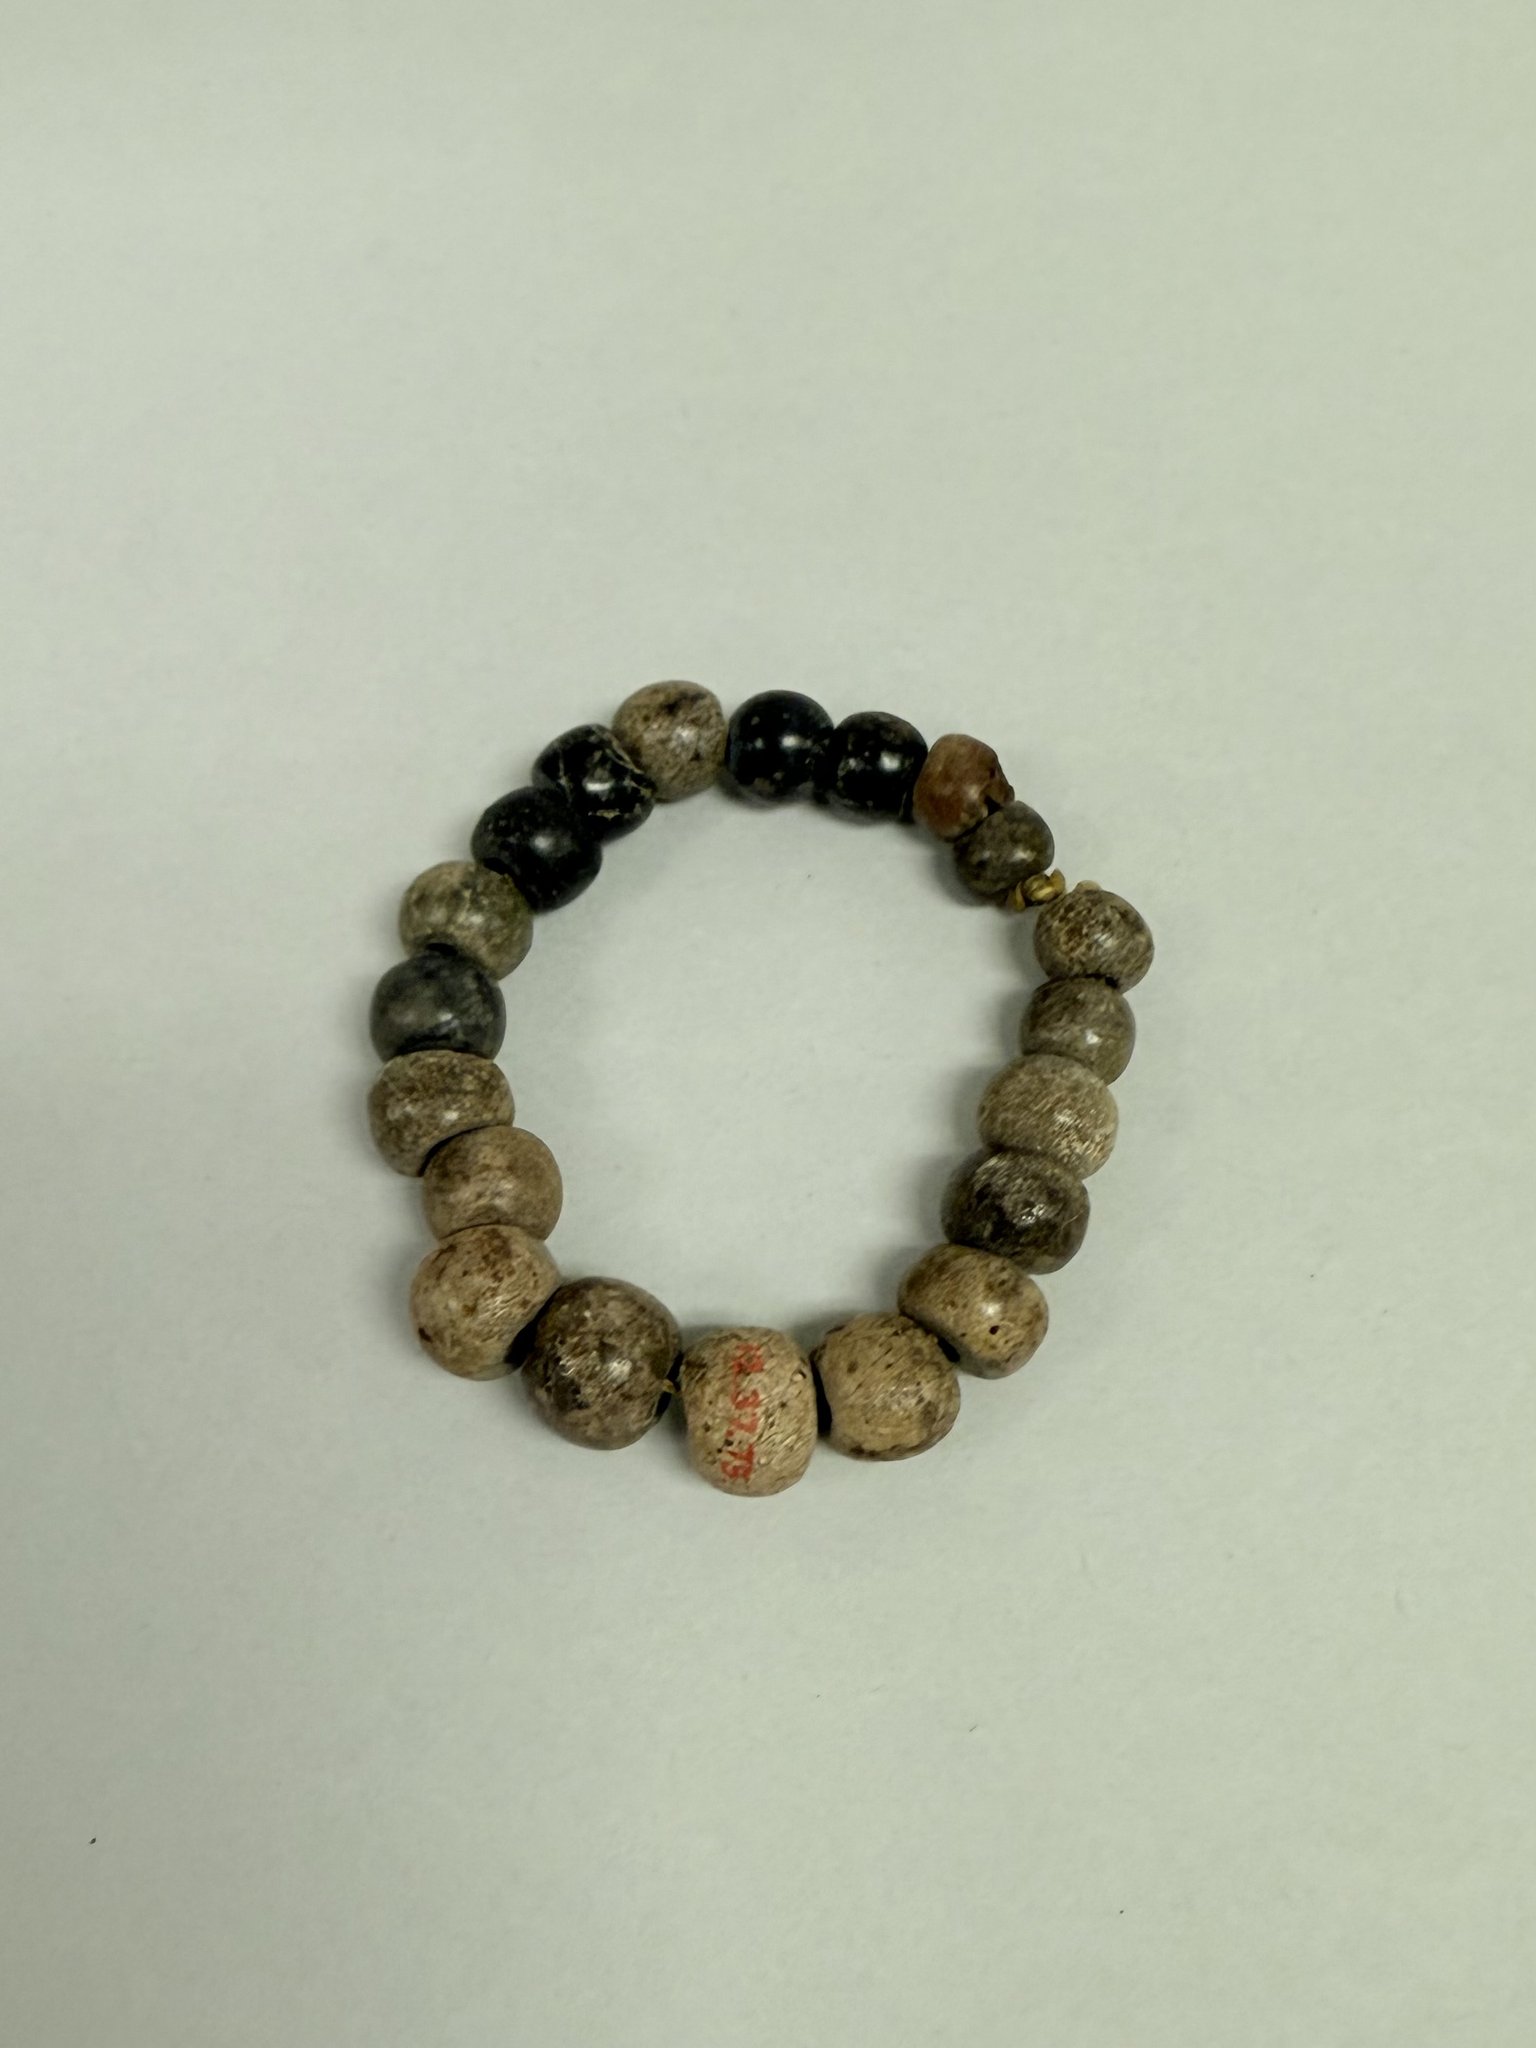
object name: bead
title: Beads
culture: japanese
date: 601-700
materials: crystal, glass